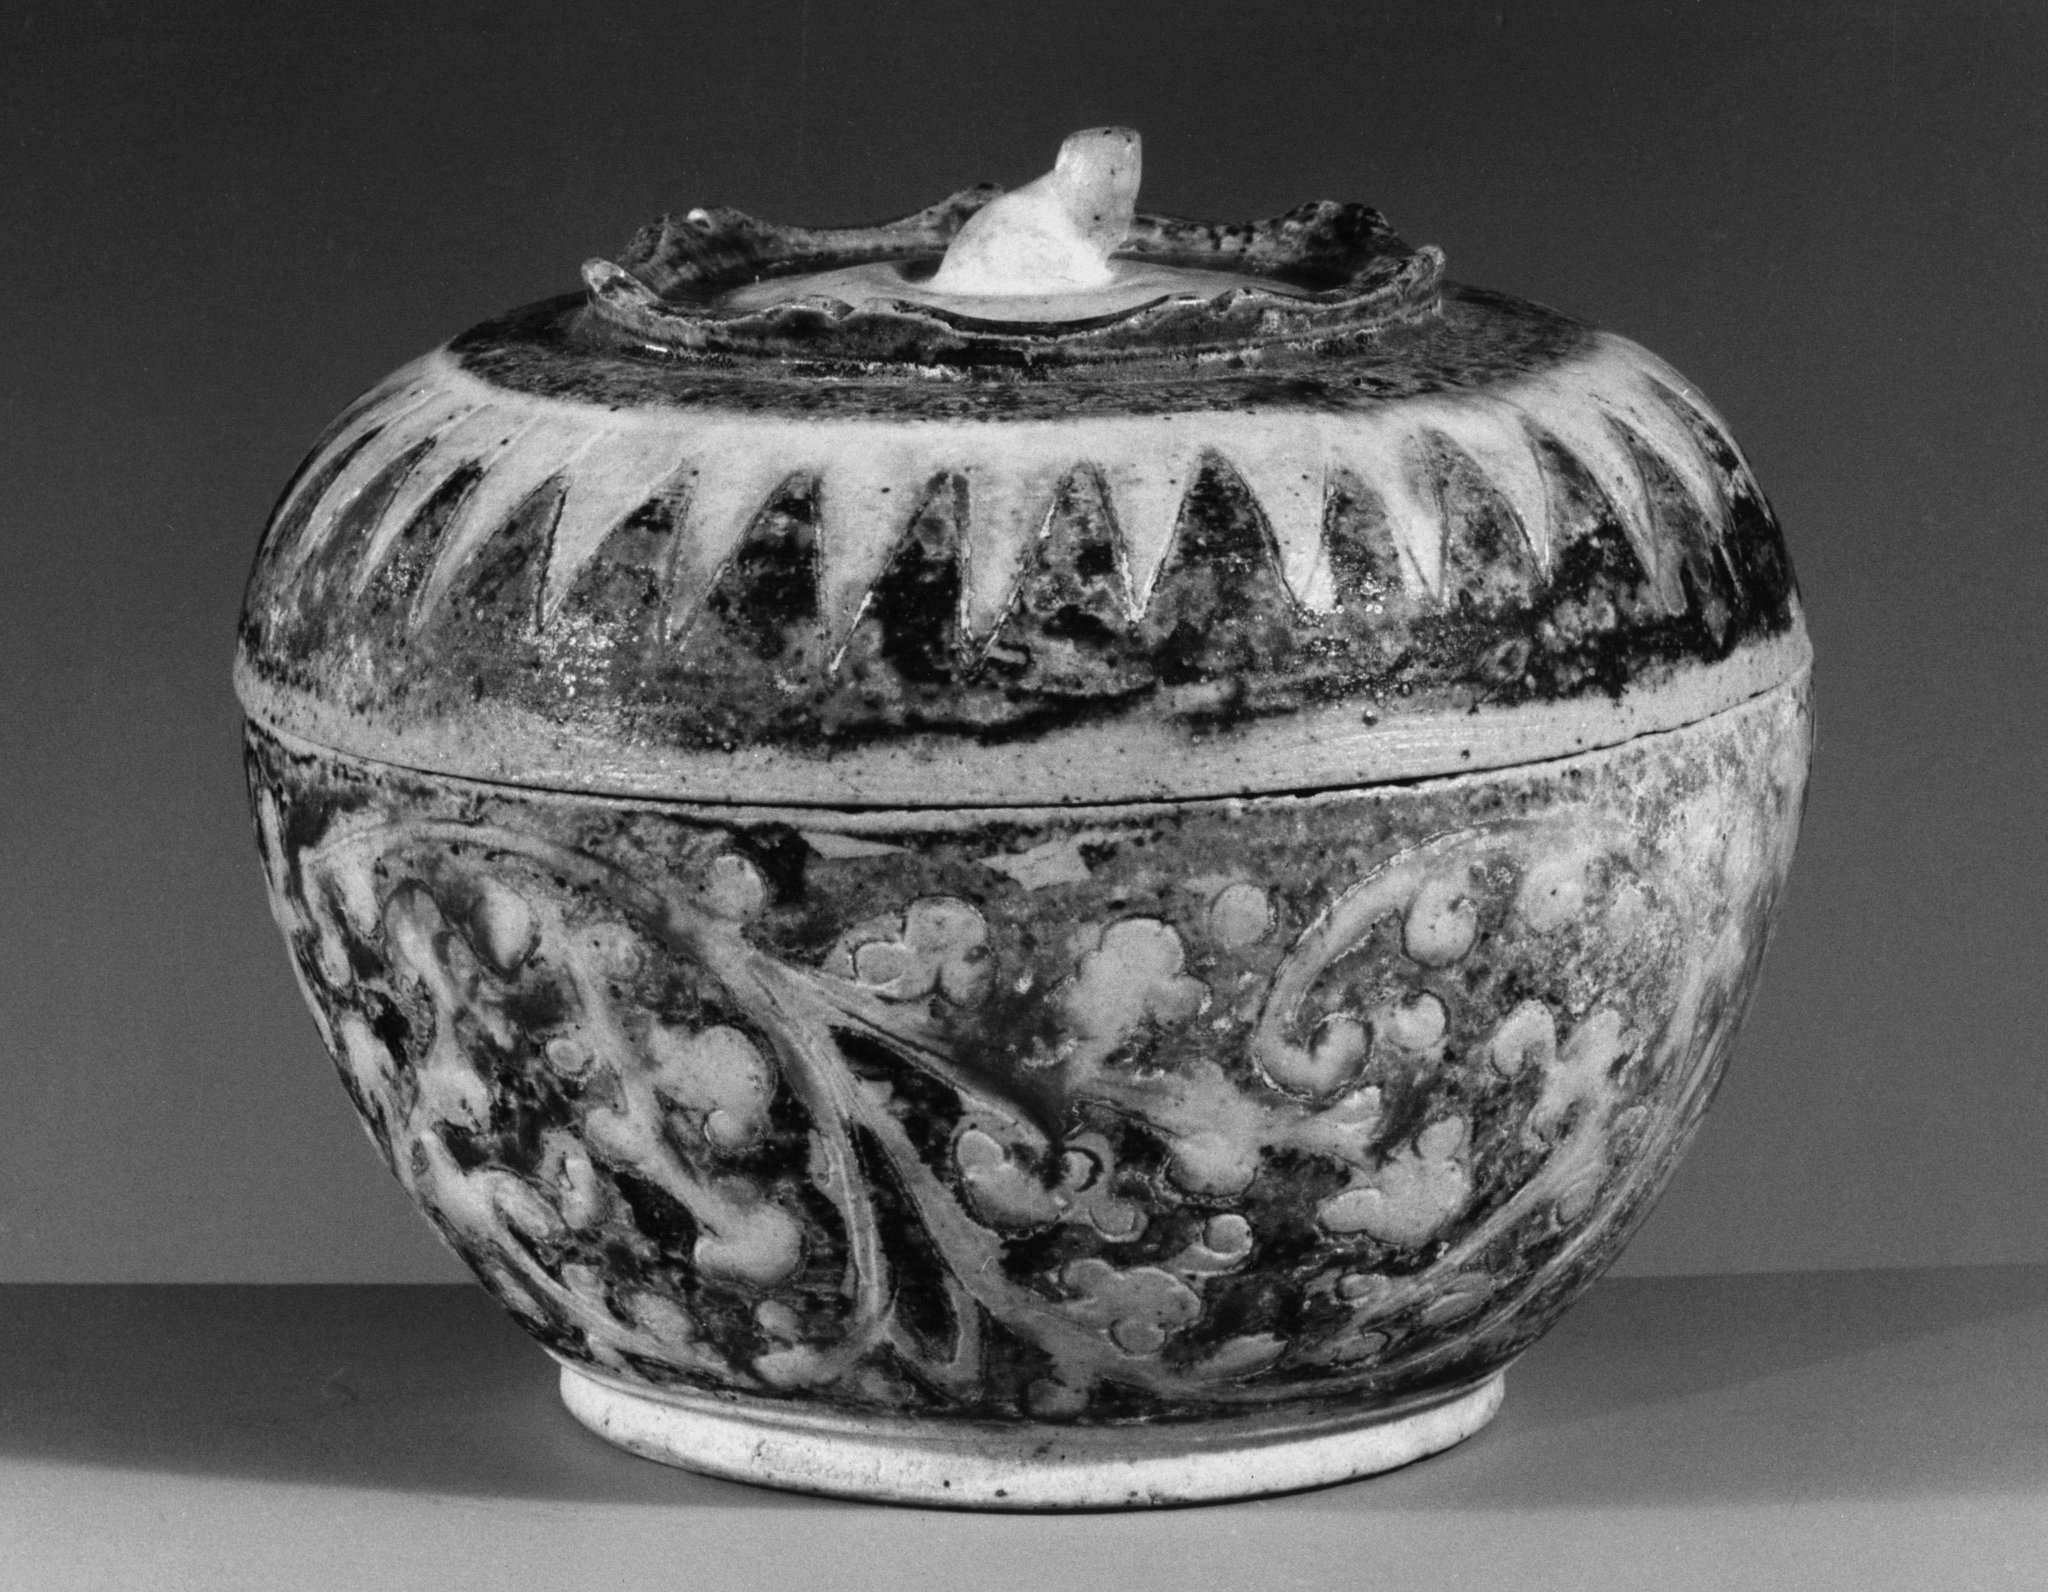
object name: vessel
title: Vessel in the Shape of a Persimmon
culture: thai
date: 1401-1500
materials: earthenware